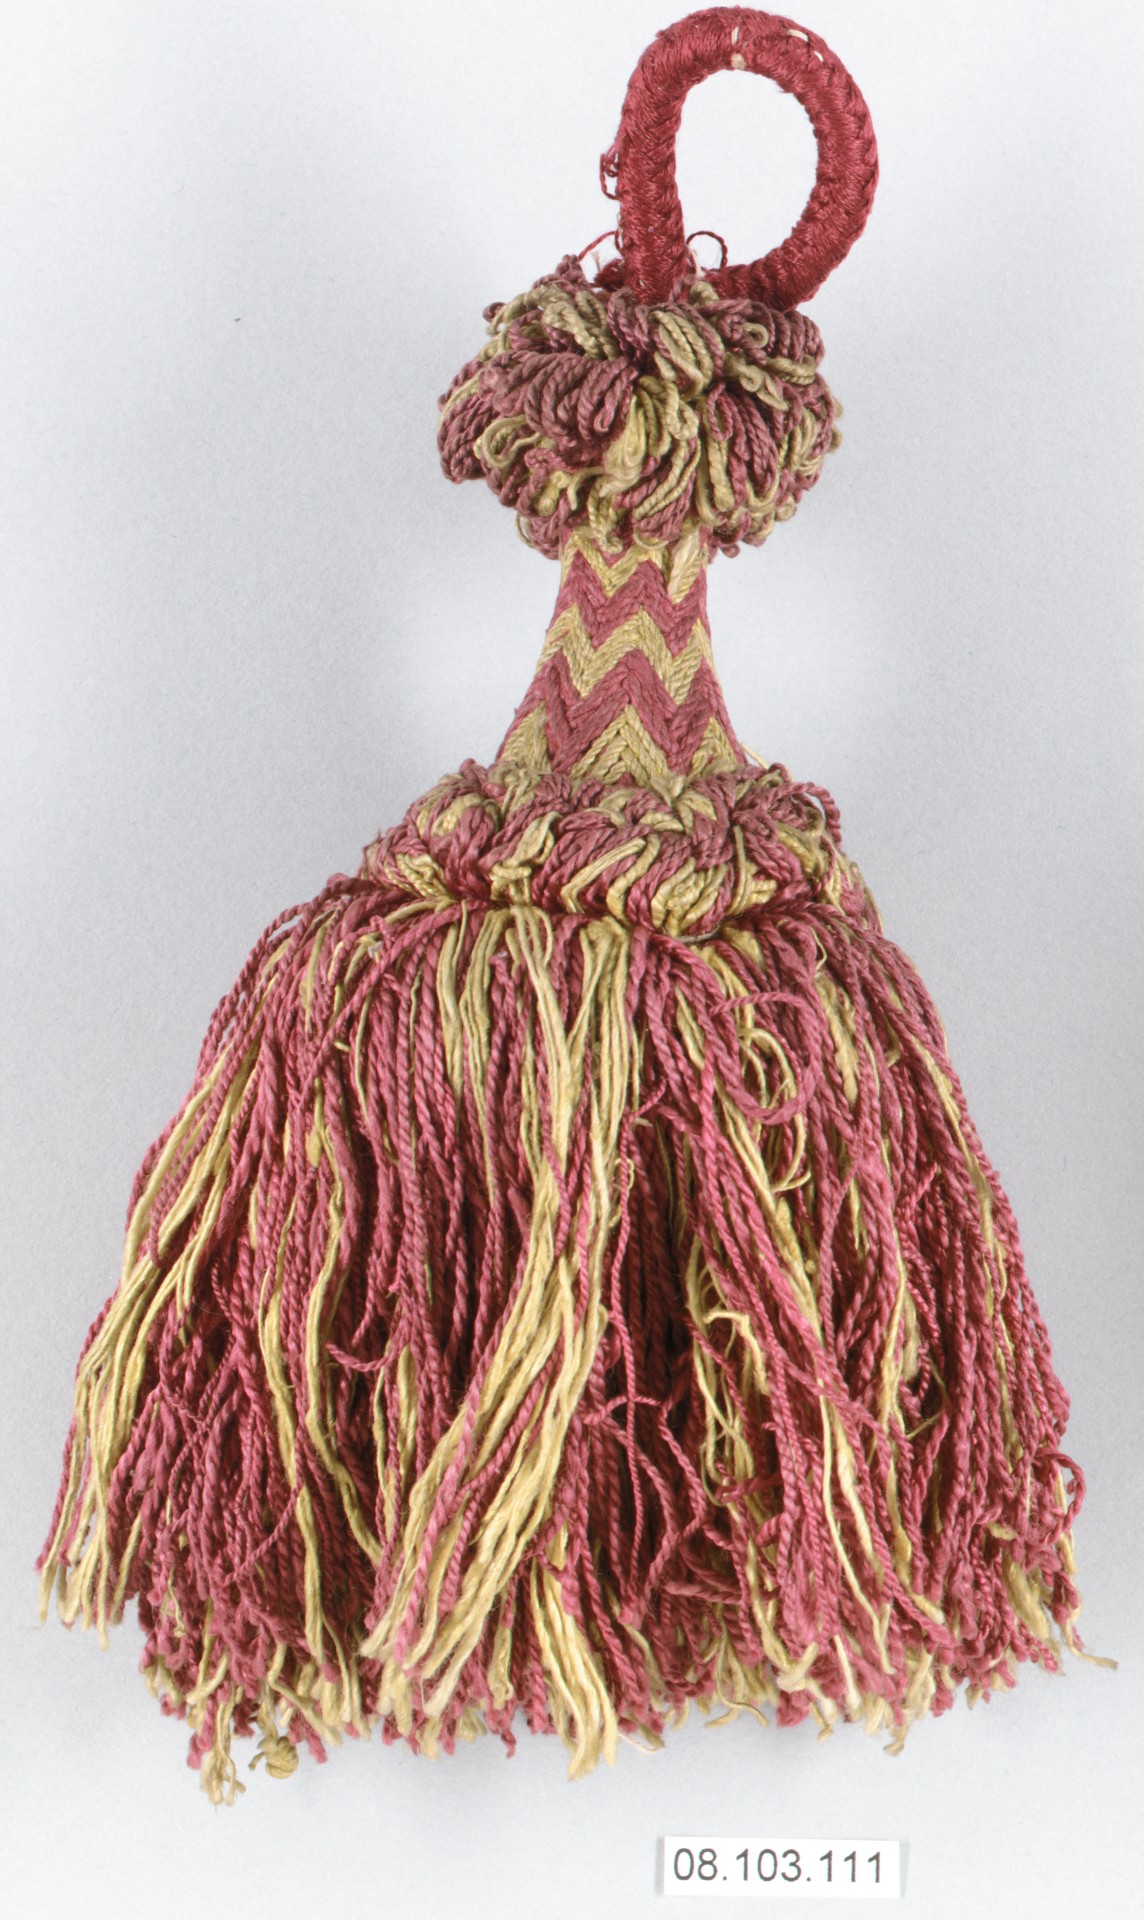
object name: tassel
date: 1567-1633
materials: silk